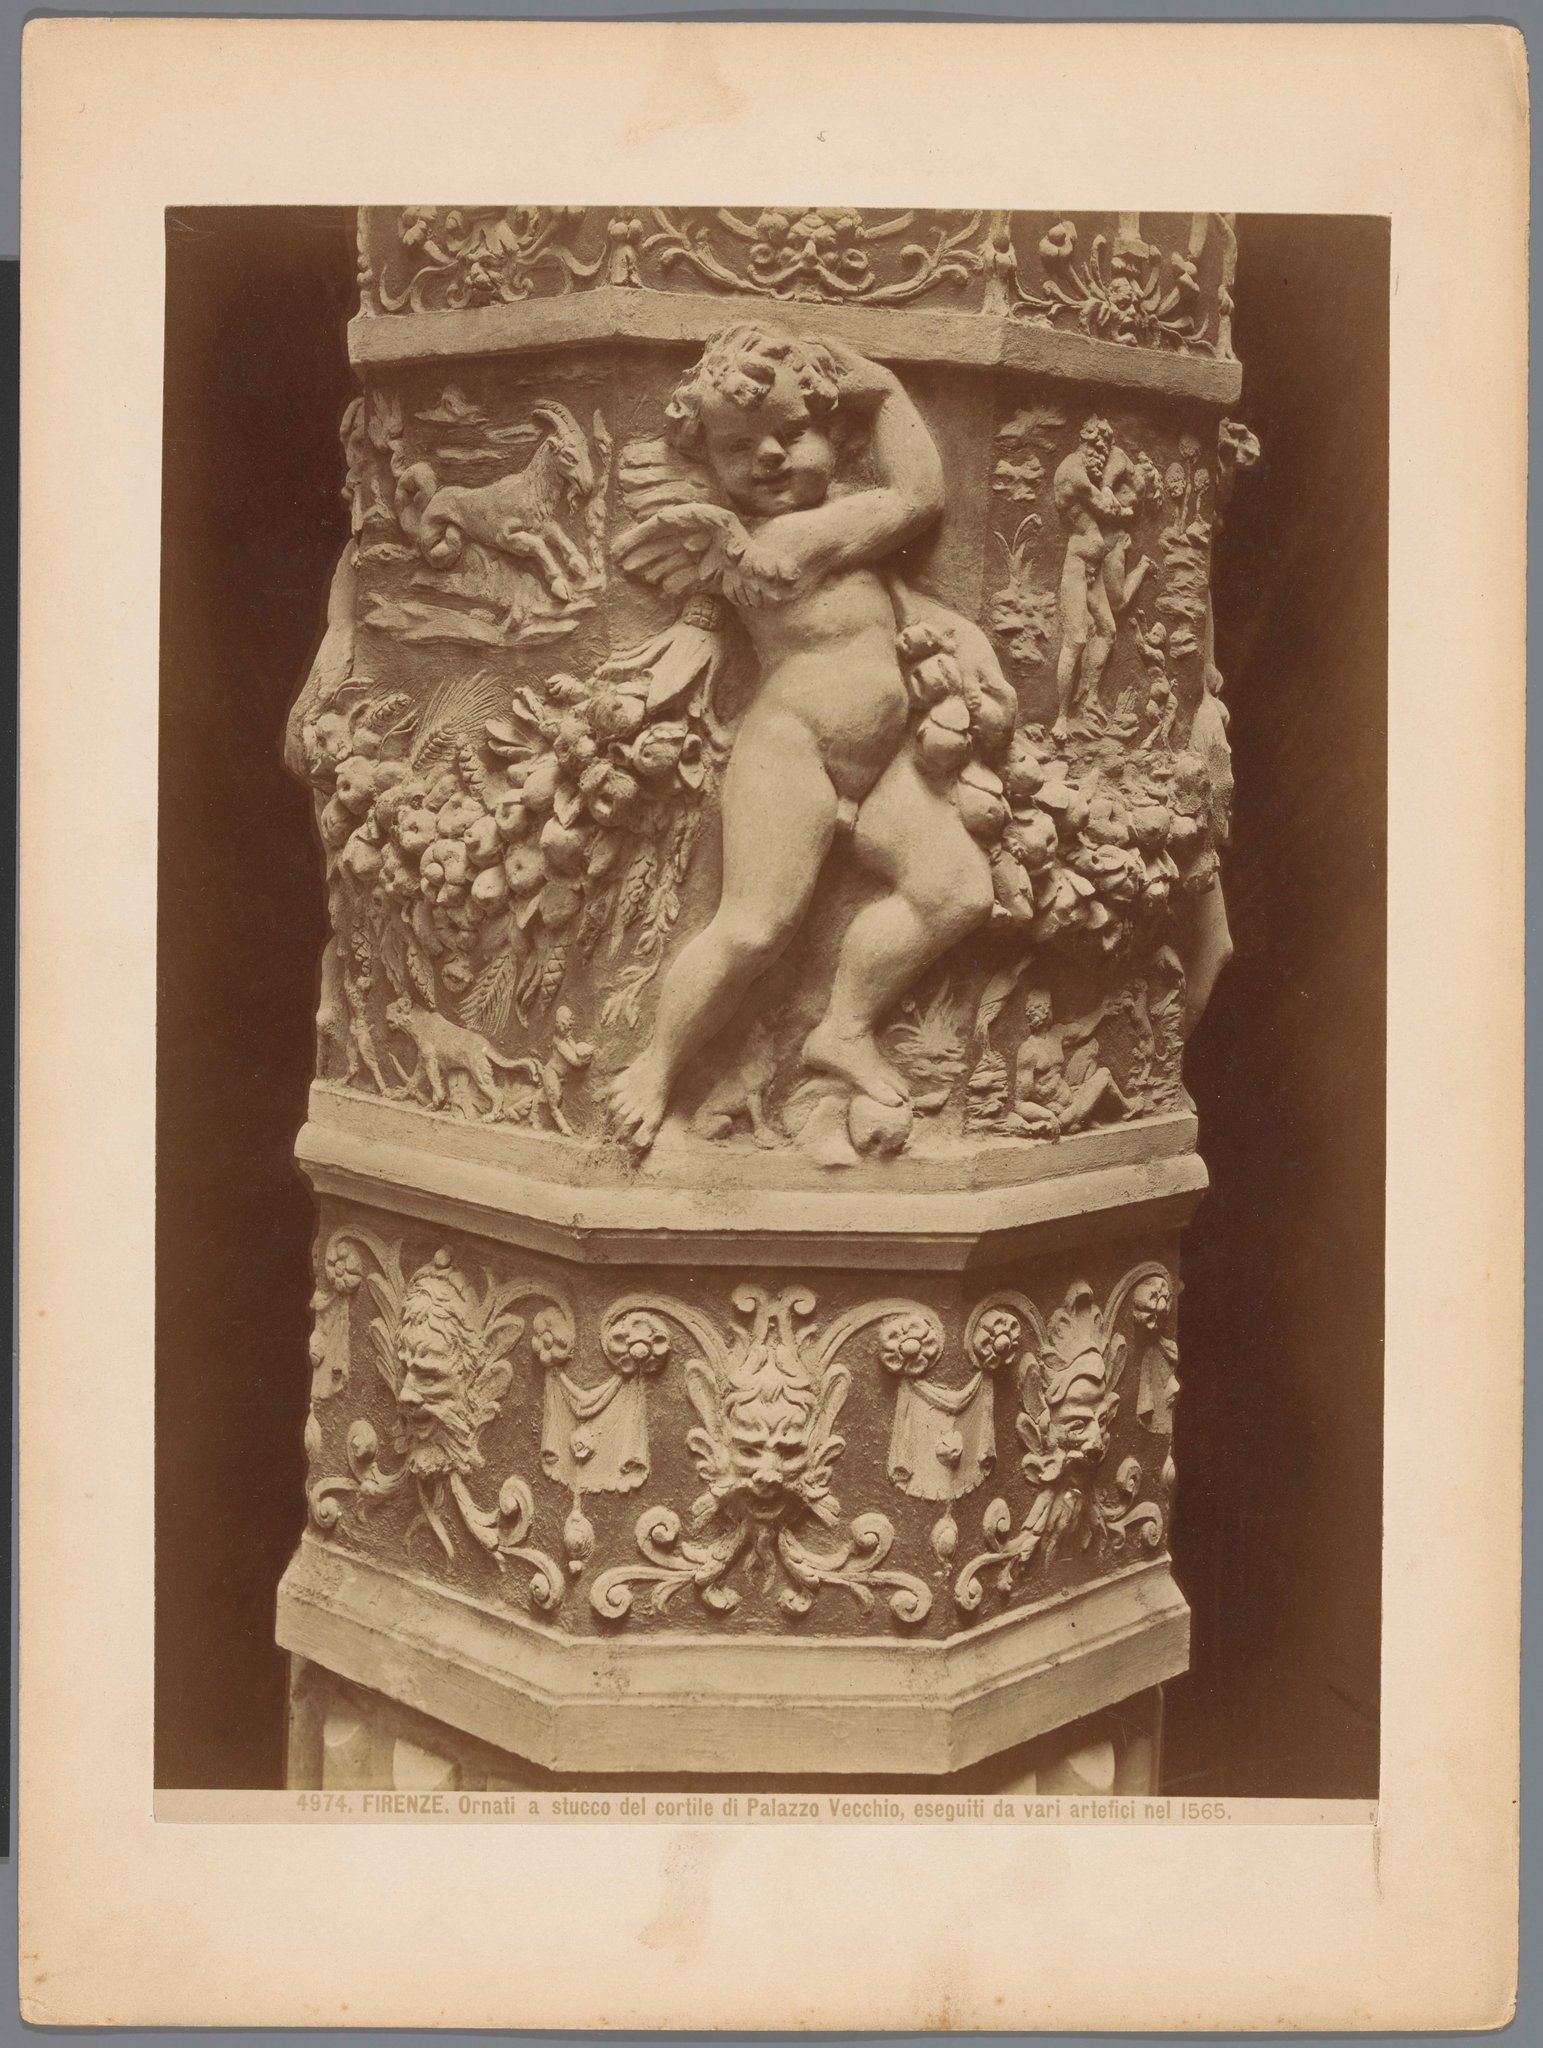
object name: photograph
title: FIRENZE. Ornati a stucco del cortile di Palazzo Vecchio, eseguiti da vari artefici nel 1565.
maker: Anonymous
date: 1875-1900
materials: cardboard, photographic support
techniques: albumen print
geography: palazzo vecchio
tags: ornaments ~ art, fruits and vegetables ~ ornament, mask, mascaron ~ ornament, cupids: 'amores', 'amoretti', 'putti'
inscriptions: collector's mark: Lugt 3937, number: ‘4974.’